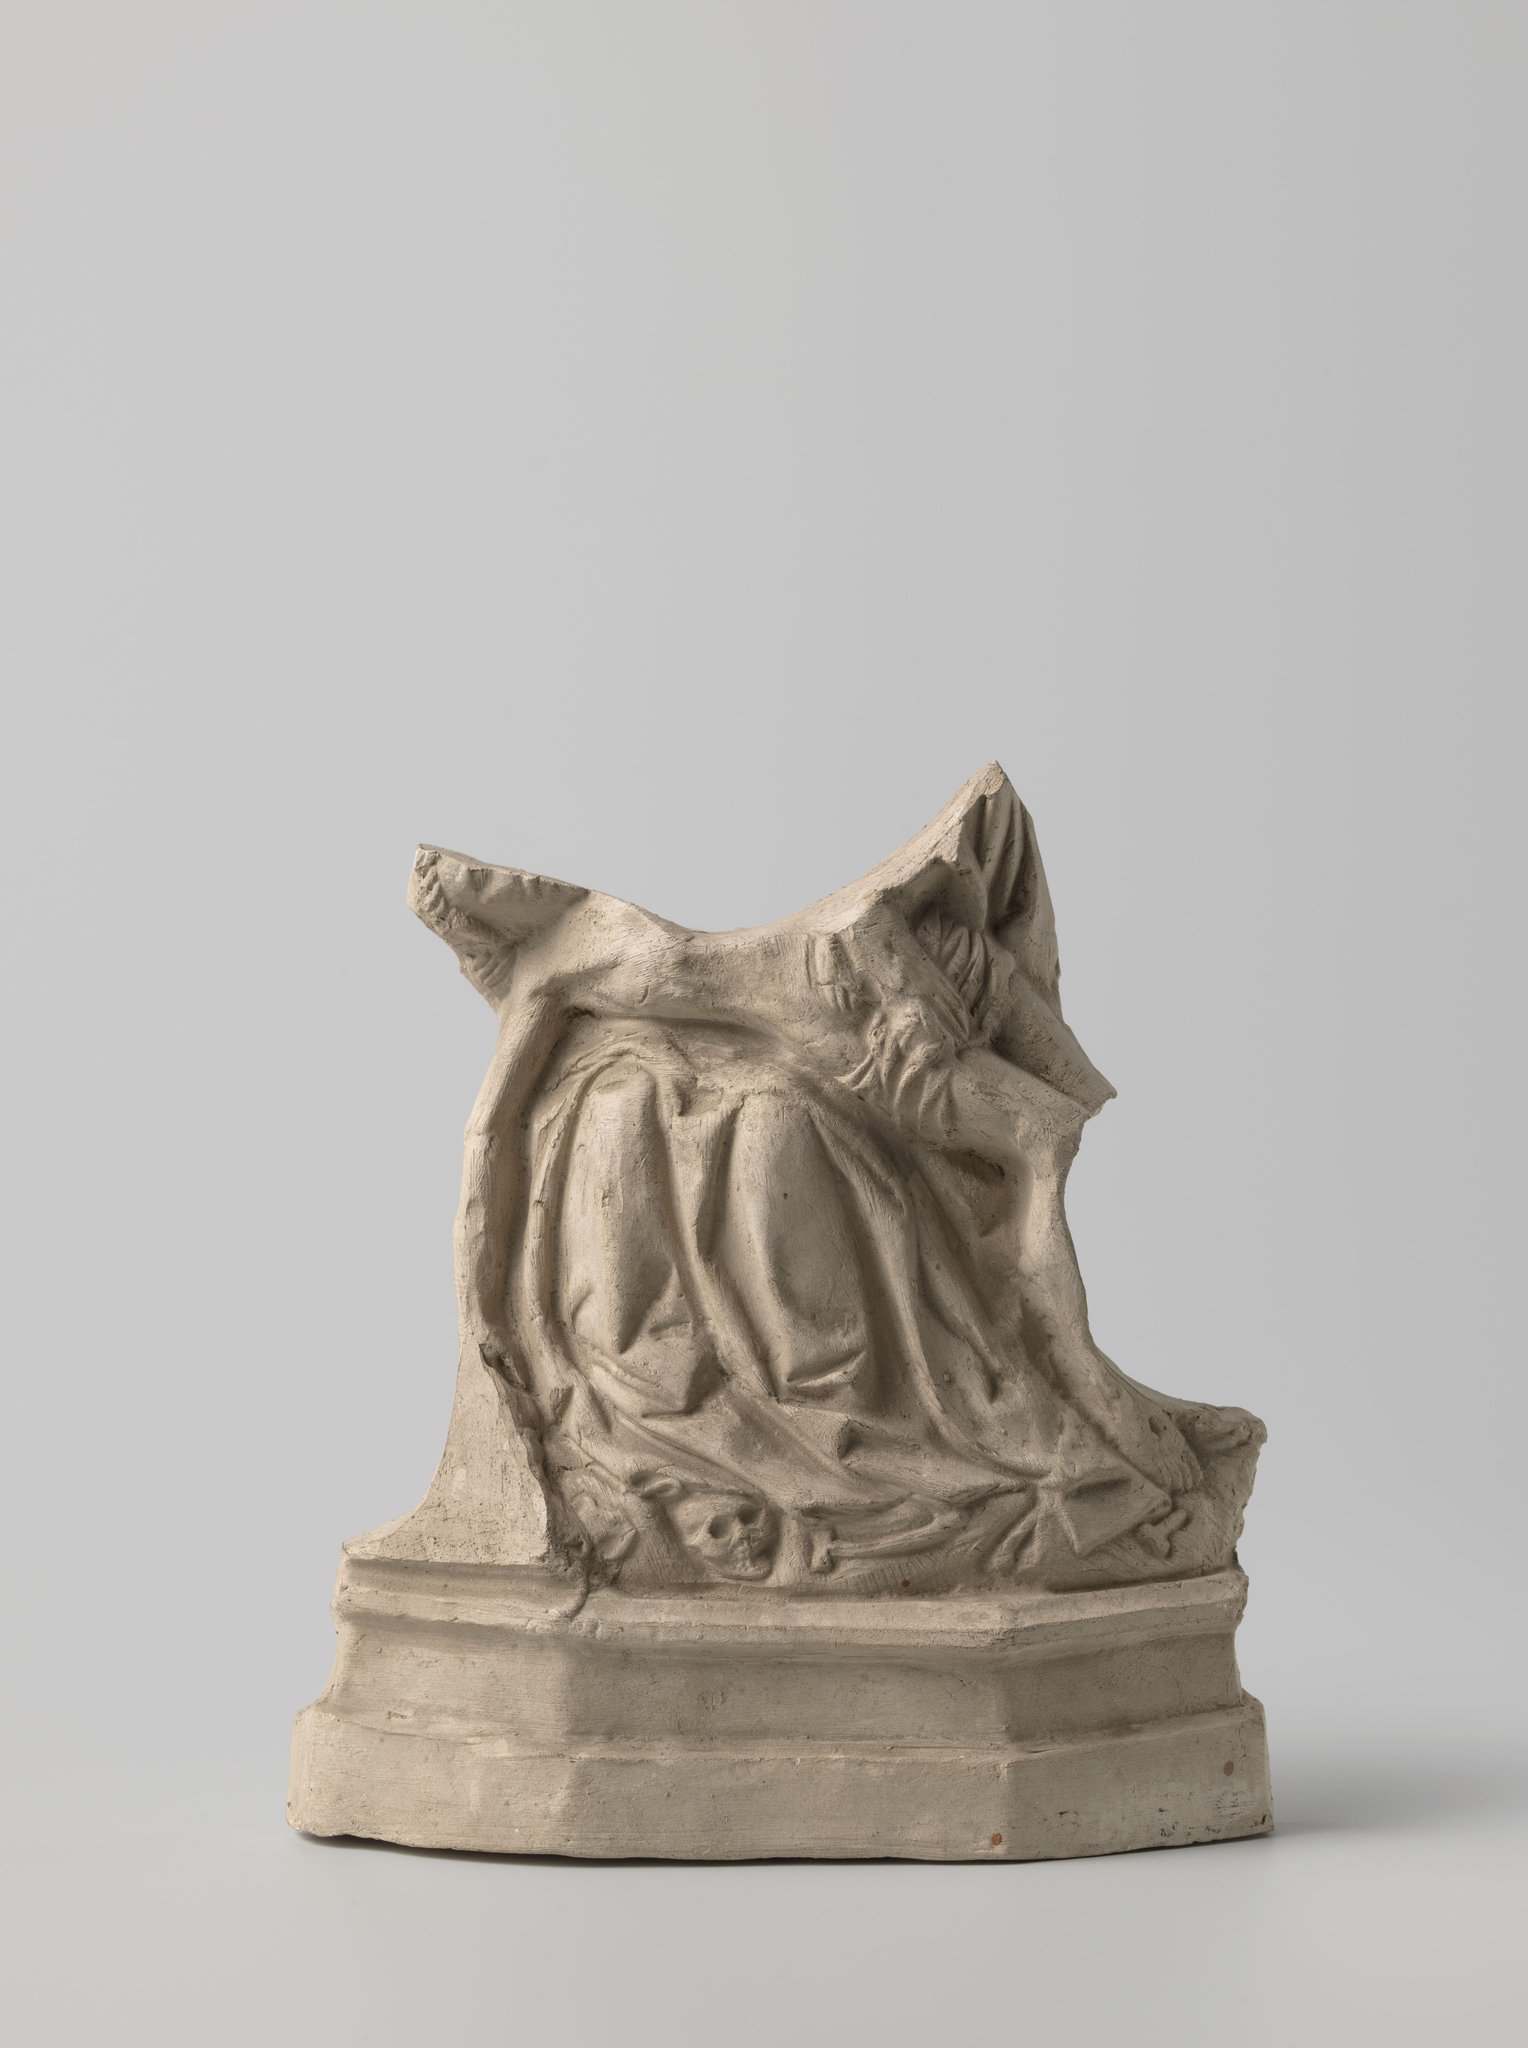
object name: fragment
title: Beeld, benedengedeelte, van een Maria met het lijk van Christus op schoot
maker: Anonymous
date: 1500-1550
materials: gypsum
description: Beeld, benedengedeelte, van een Maria met het lijk van Christus op schoot. Afgietsel in gips. De vorm bevindt zich in de gemeenteverzameling in Utrecht.